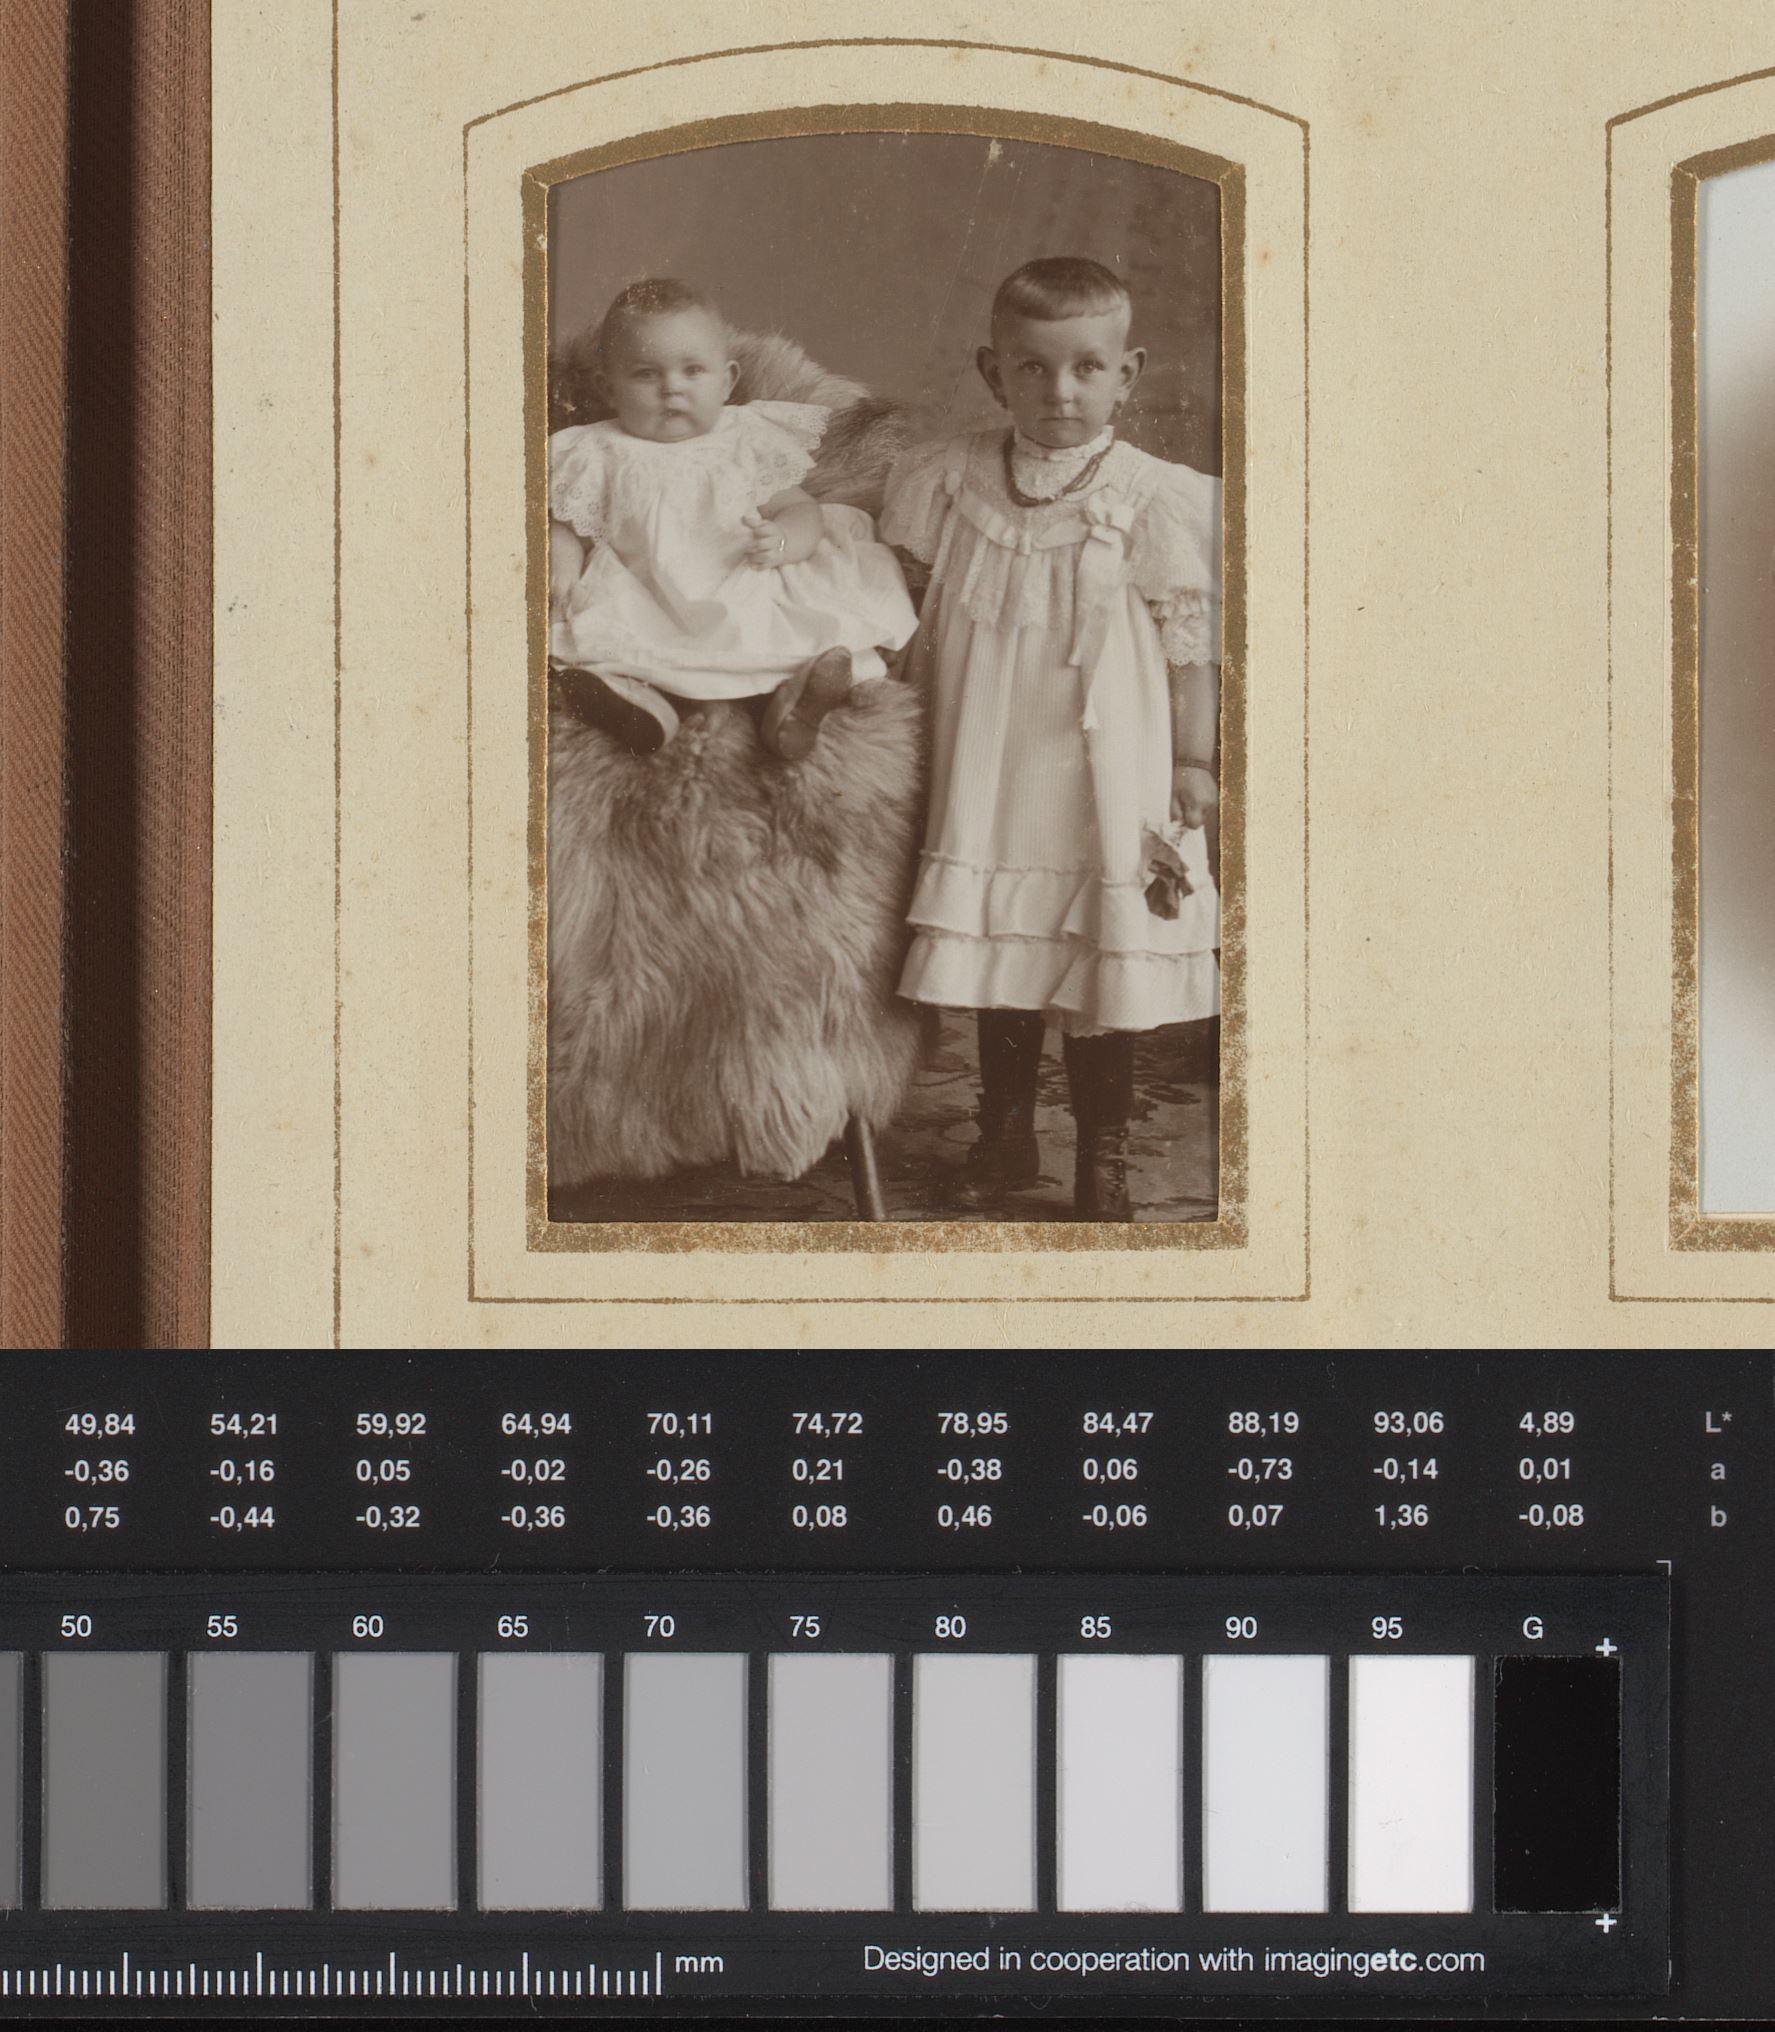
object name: photograph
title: Portret van een zittende baby en een staand meisje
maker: josephus hendrikus petrus coppens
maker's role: fotograaf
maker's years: 1864-1941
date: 1889-1925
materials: cardboard, photographic support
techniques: collodion silver print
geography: purmerend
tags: sitting figure, historical persons - bb - woman, girl (child between toddler and youth), infant, baby ~ the ages of man, standing figure - aa - female human figure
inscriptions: inscription: ‘J. H. P. Coppens/ Purmerend.’